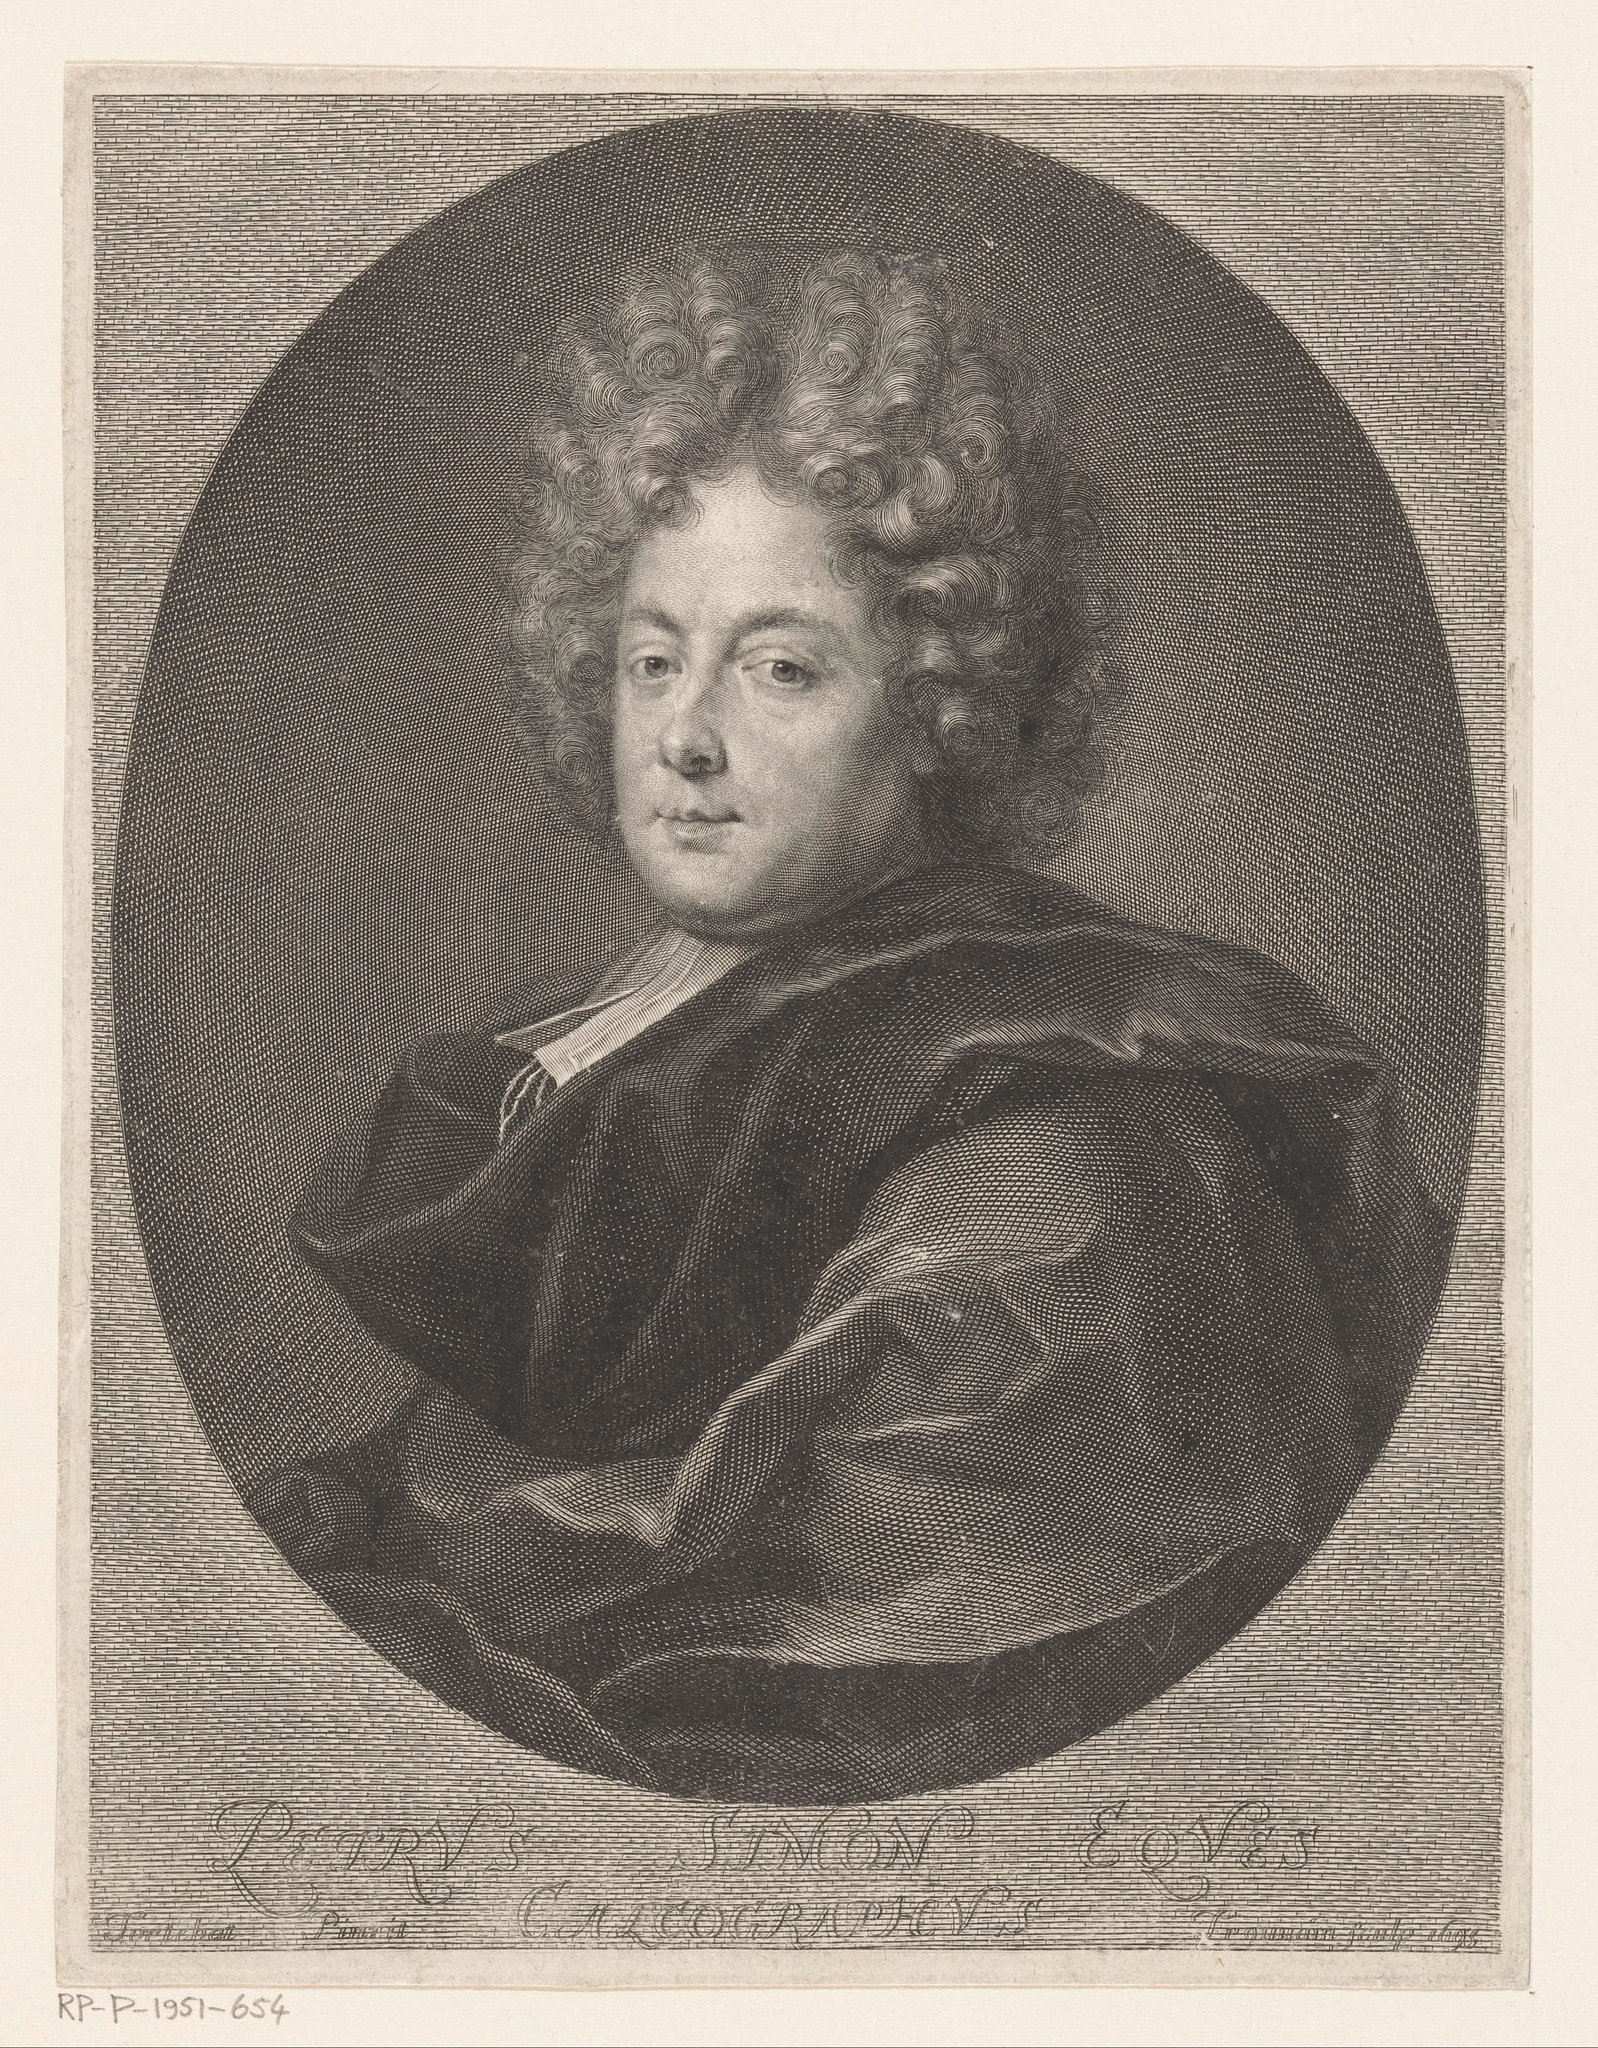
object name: print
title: Petrus Simon Eques Calcographus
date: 1693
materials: paper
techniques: engraving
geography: france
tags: pierre simon (i), historical persons, portrait, self-portrait of artist, wig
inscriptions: collector's mark: Lugt 2228